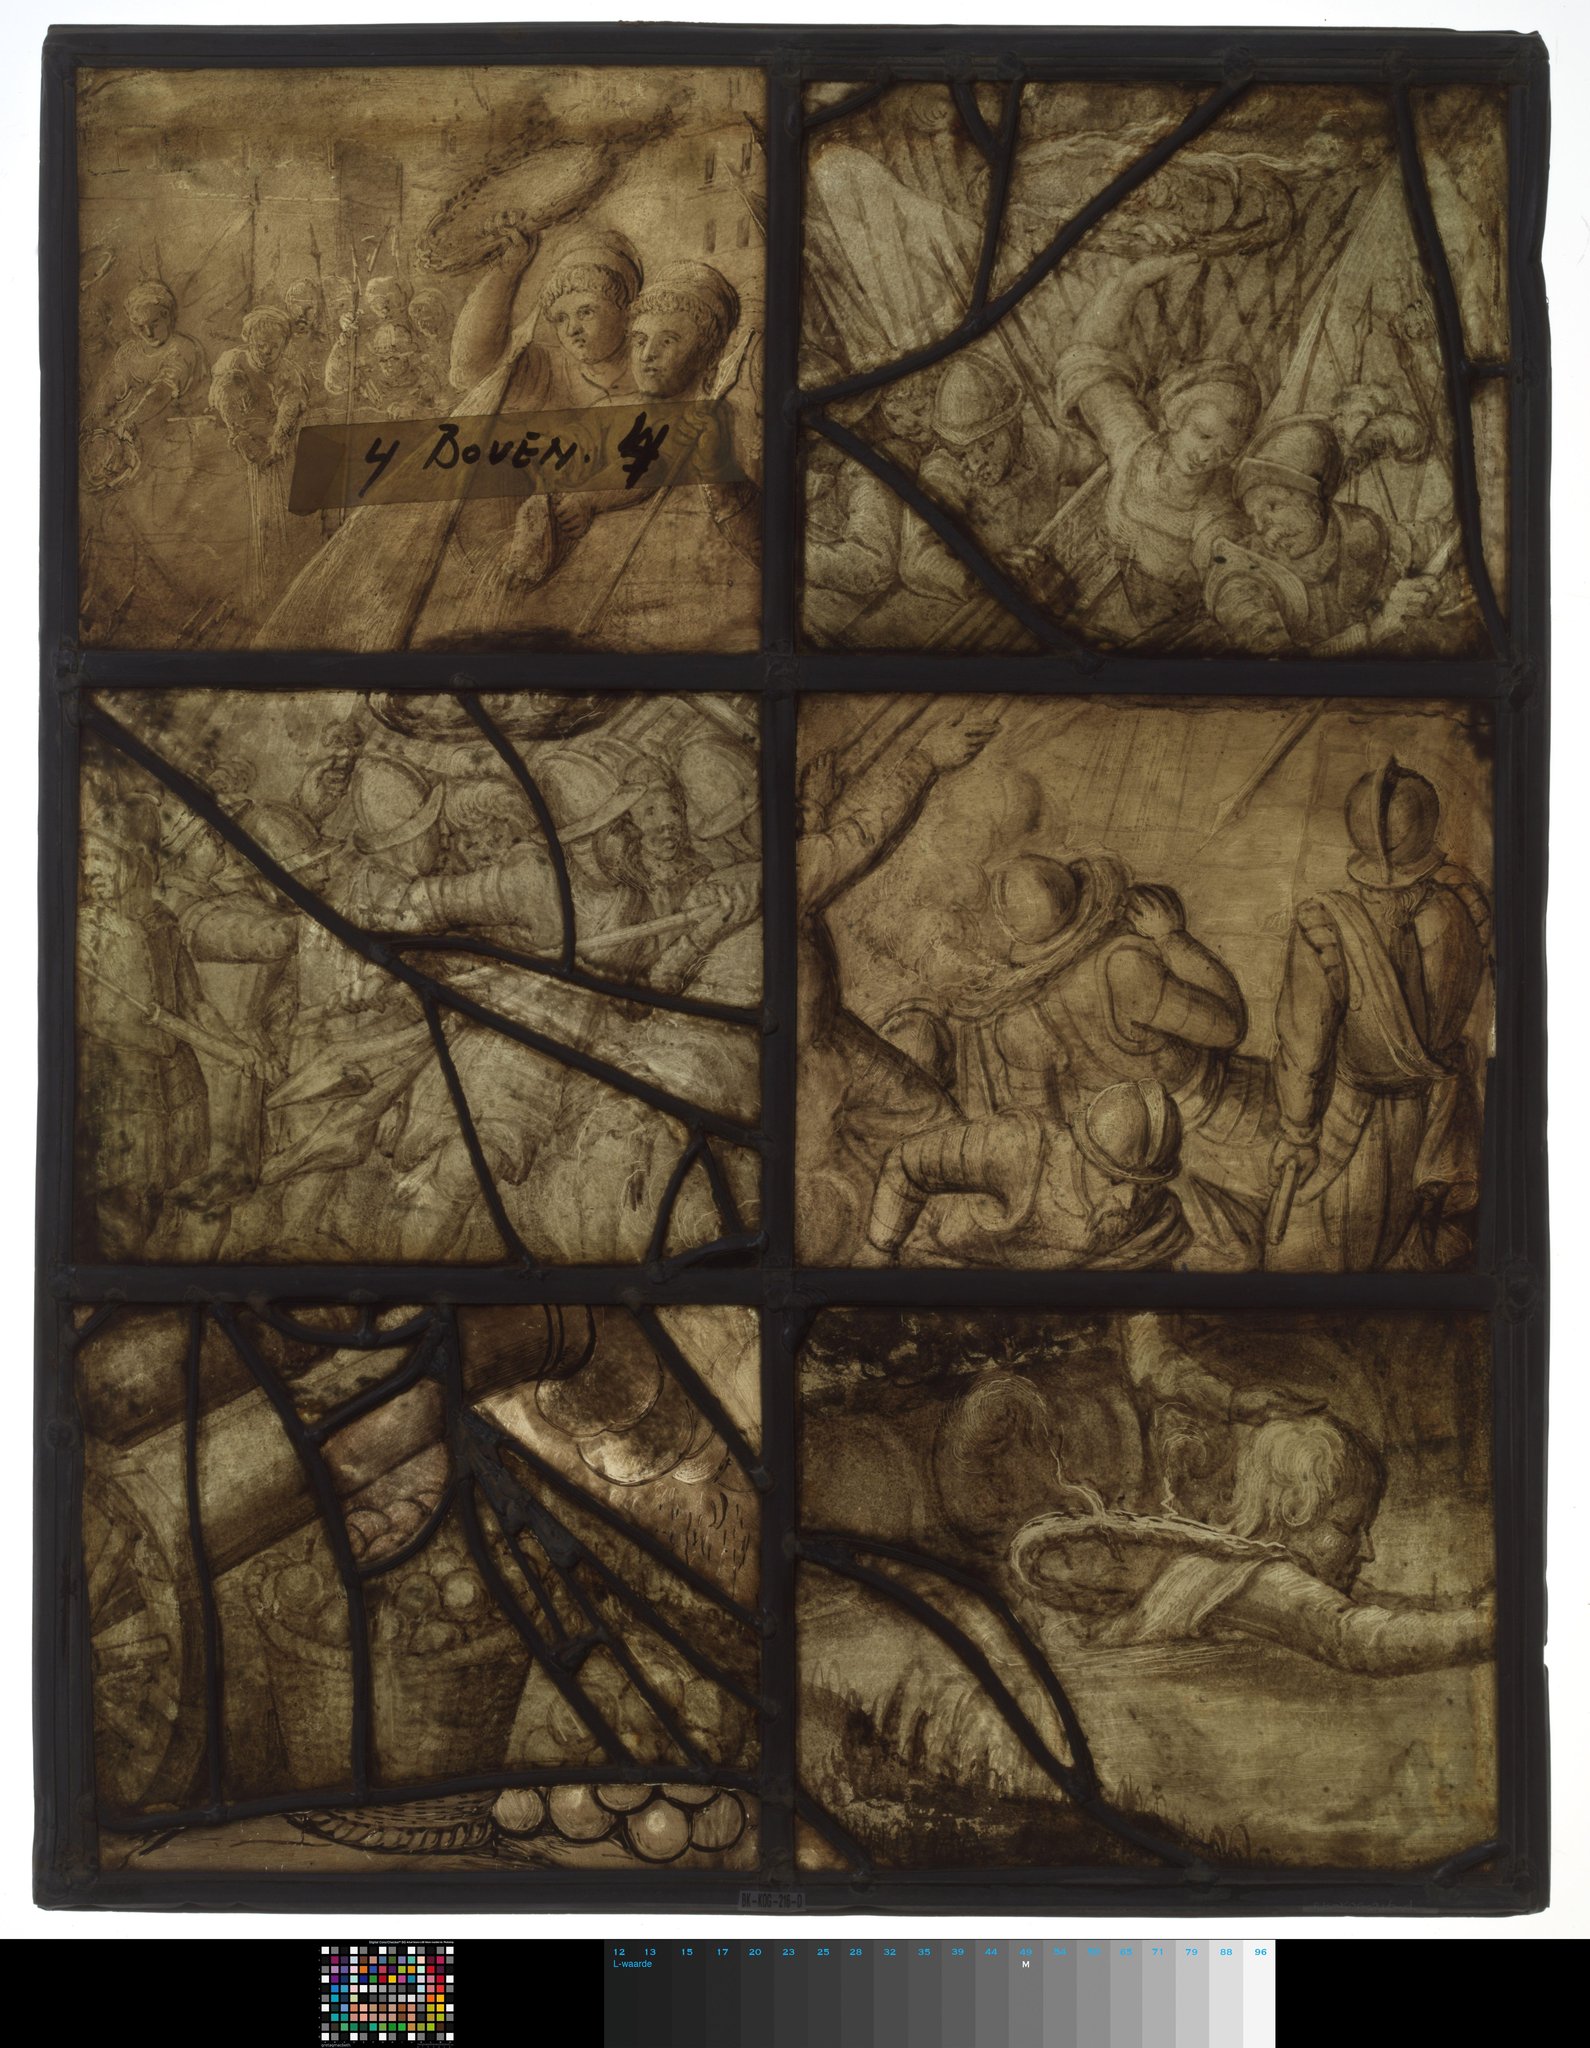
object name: light window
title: Ruit met het wapen van Alkmaar met onderschrift "Alkmaria Victrix 1573"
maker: Anonymous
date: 1573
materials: glass, lead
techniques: leading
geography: netherlands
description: Ruit, glas-in-lood, bestaande uit zestien afzonderlijke panelen die tezamen het wapen van Alkmaar laten zien. Onderschrift: ALKMARIA VICTRIX. Gedateerd 1573.